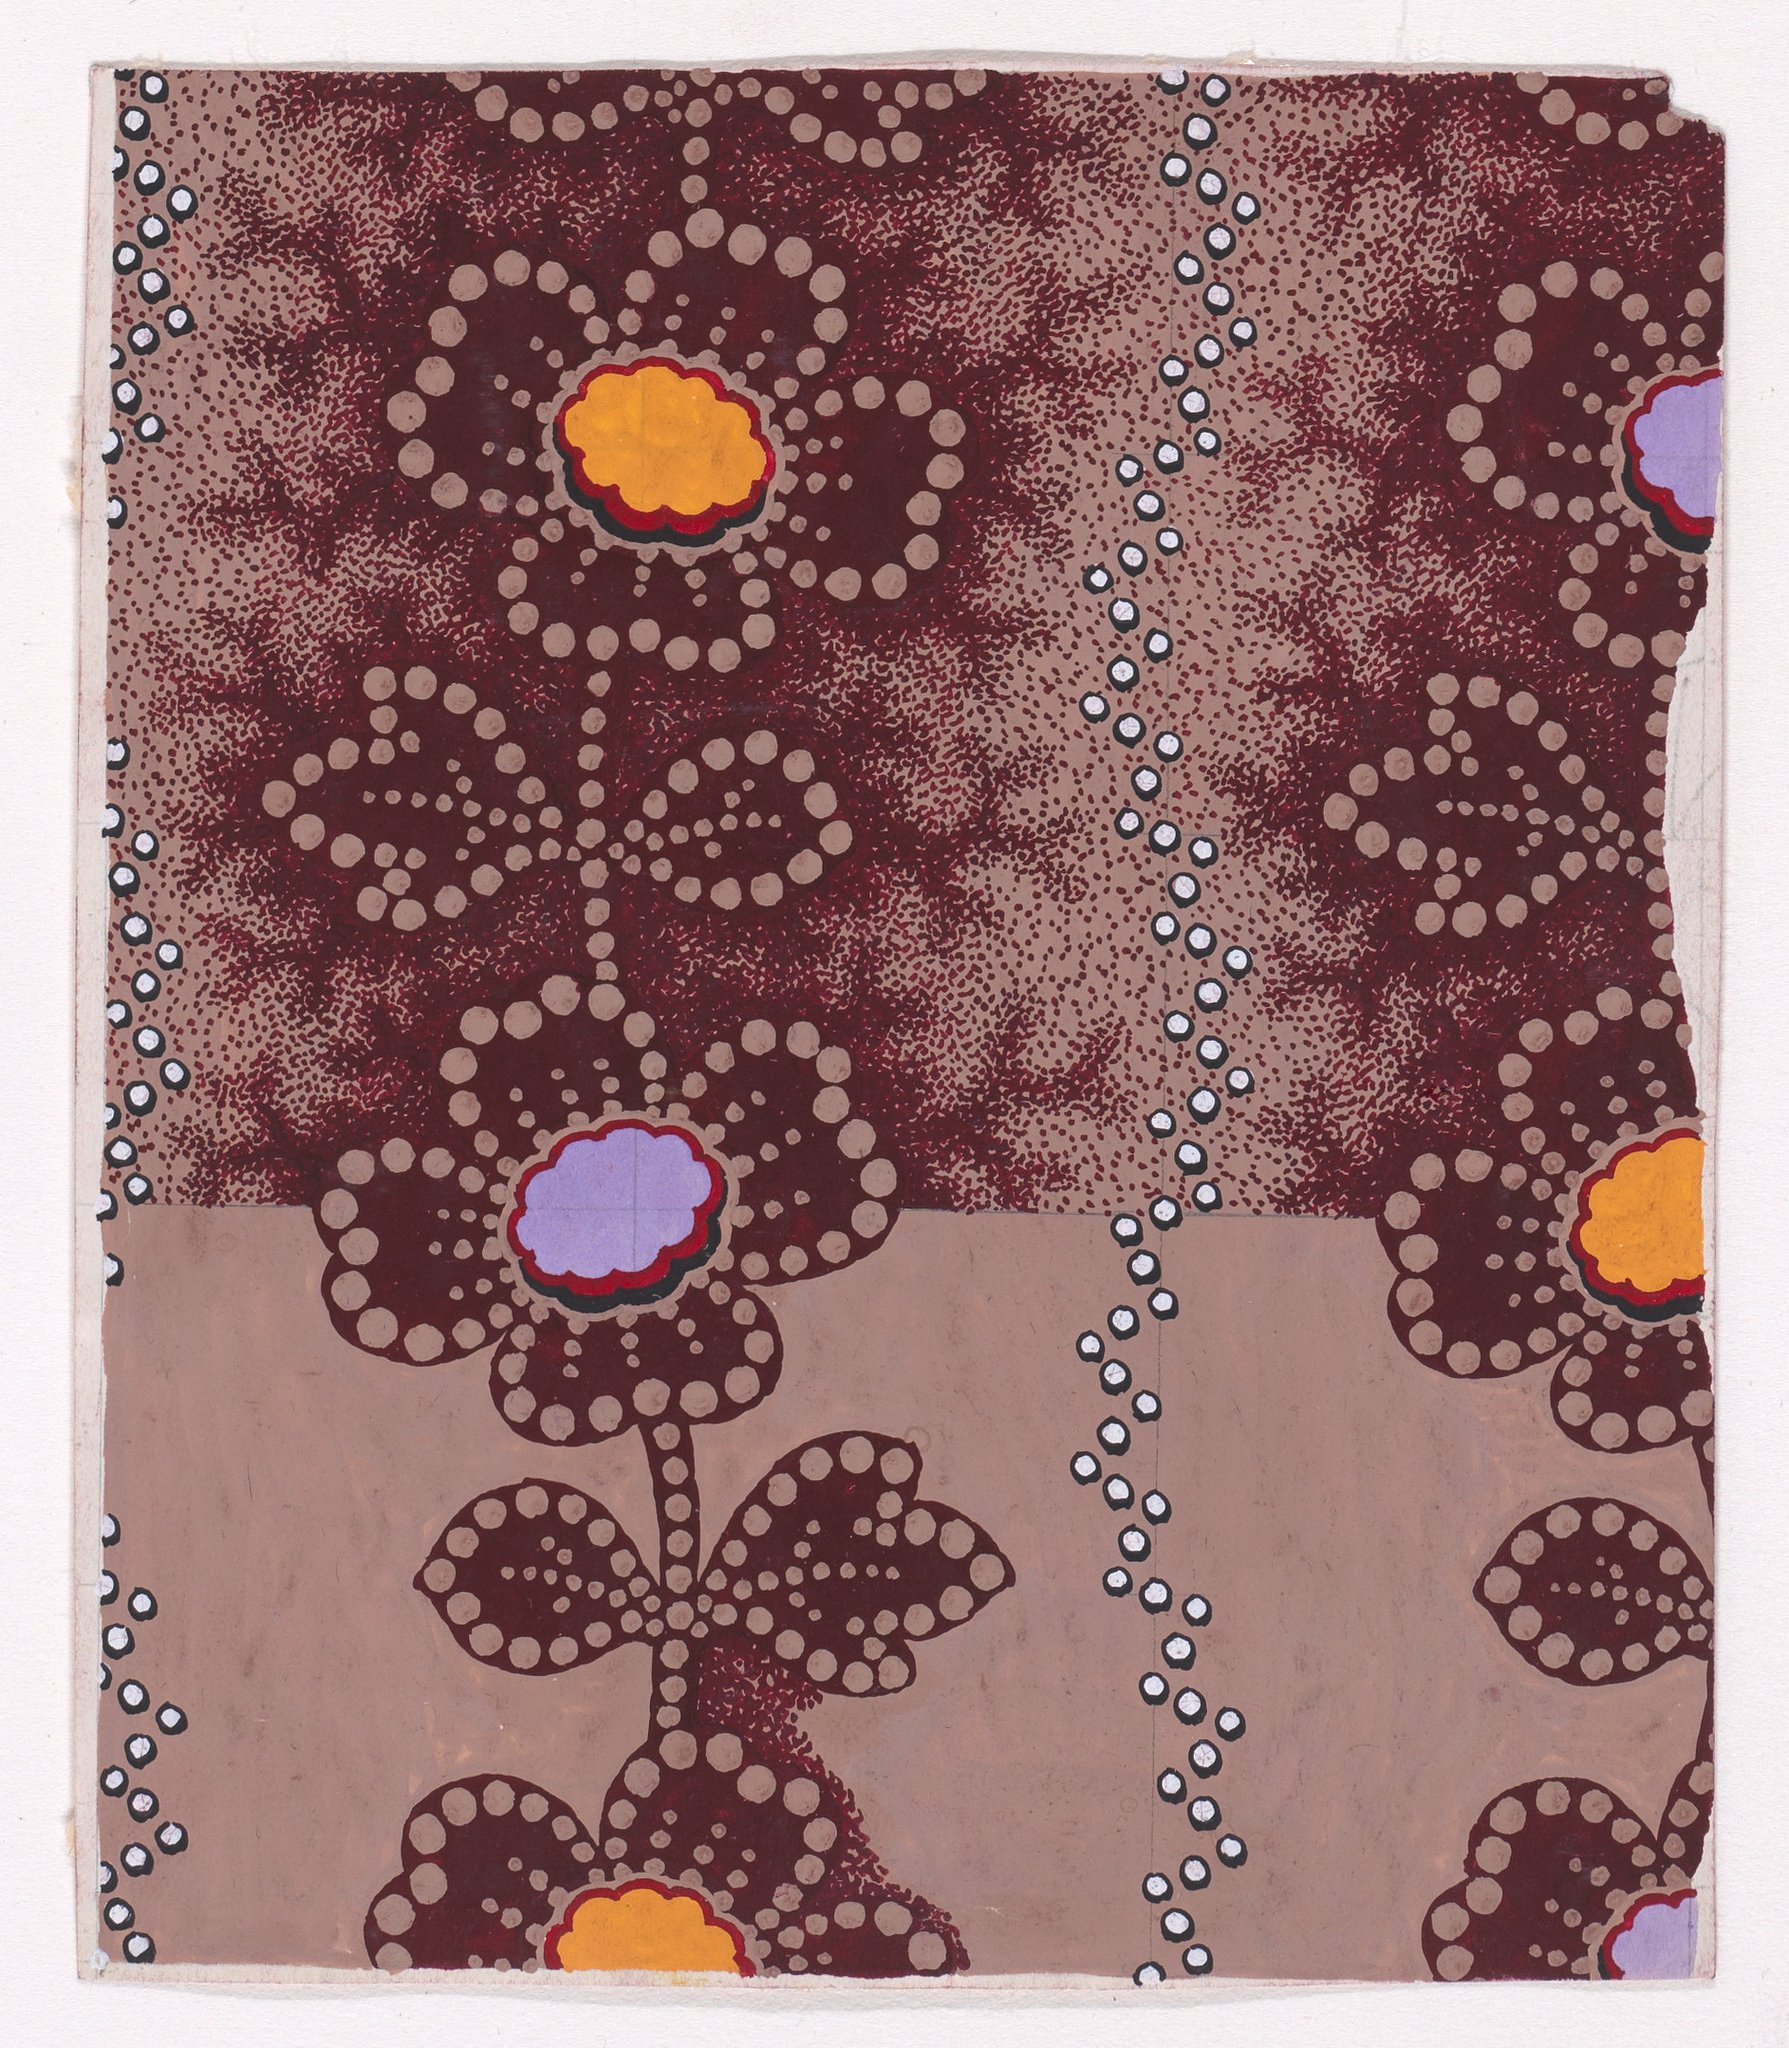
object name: drawing ornament architecture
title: Textile Design with Undulating Garlands of Stylized Flowers and Leaves Separated by Undulating Zig-Zagging Strips of Pearls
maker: anonymous, alsatian, 19th century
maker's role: artist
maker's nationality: alsatian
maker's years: 1800-1900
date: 1840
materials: gouache